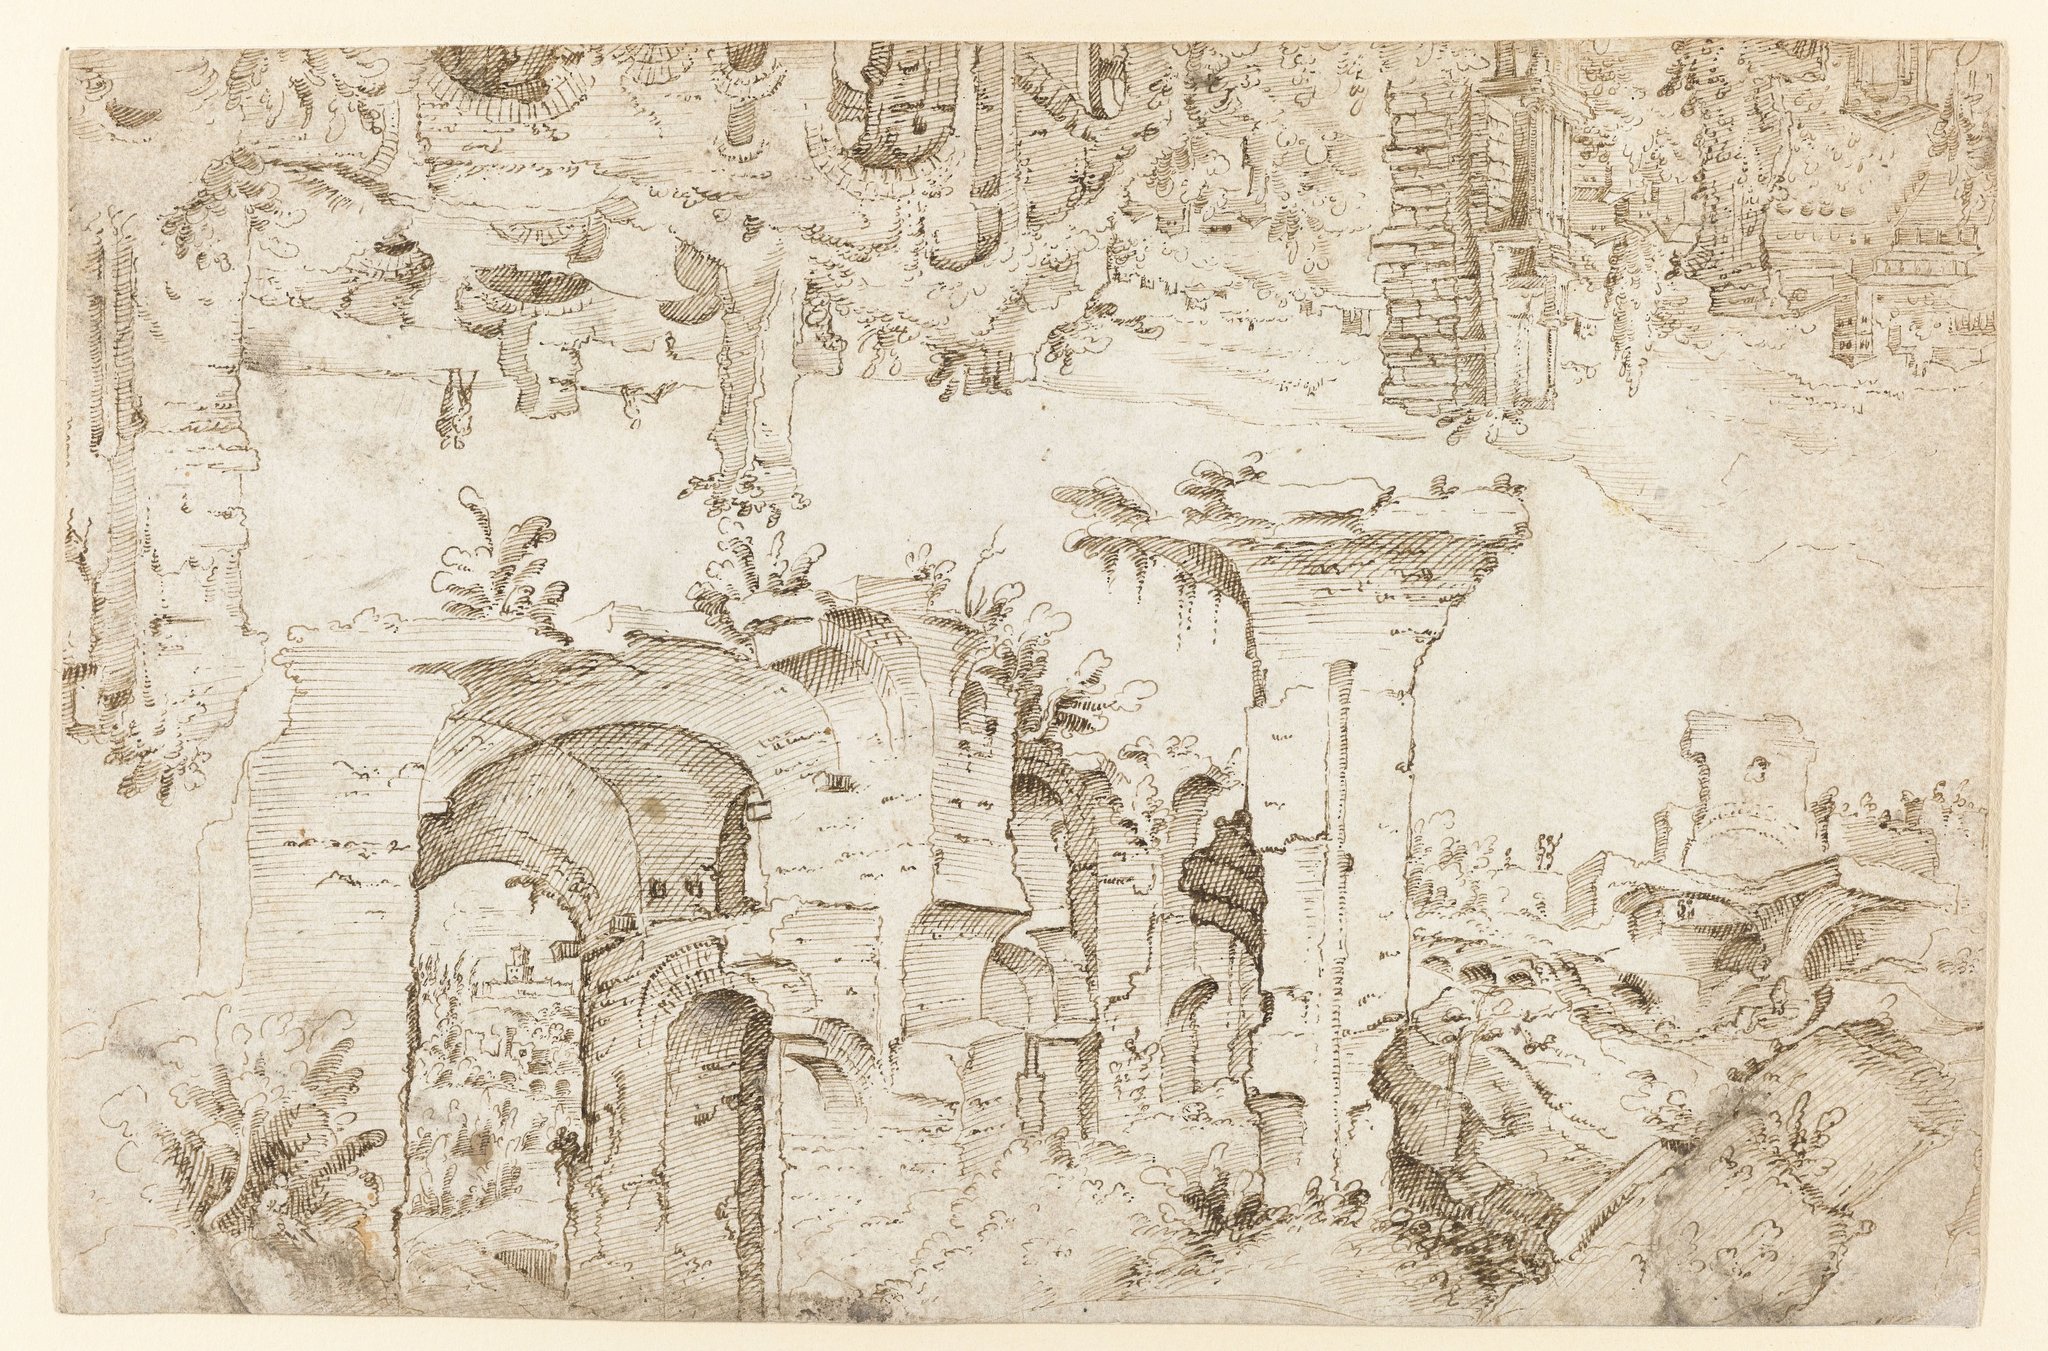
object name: drawing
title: Ruins on the Palatine Hill in Rome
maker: martinus van heemskerck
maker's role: draughtsman, painter, print maker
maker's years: 1498-1574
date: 1532-1537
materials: ink, paper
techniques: pen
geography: rome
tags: ruin of a building ~ architecture, landscape with ruins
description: Heemskerck was captivated not only by contemporary Italian art. This is a splendid example of the many surviving drawings of the remains of classical antiquity that Heemskerck made in Rome. The overgrown ruins underscore the bygone grandeur of the once mighty Roman Empire. In order to make optimum use of the precious paper, Heemskerck drew on the top and bottom of the sheet.